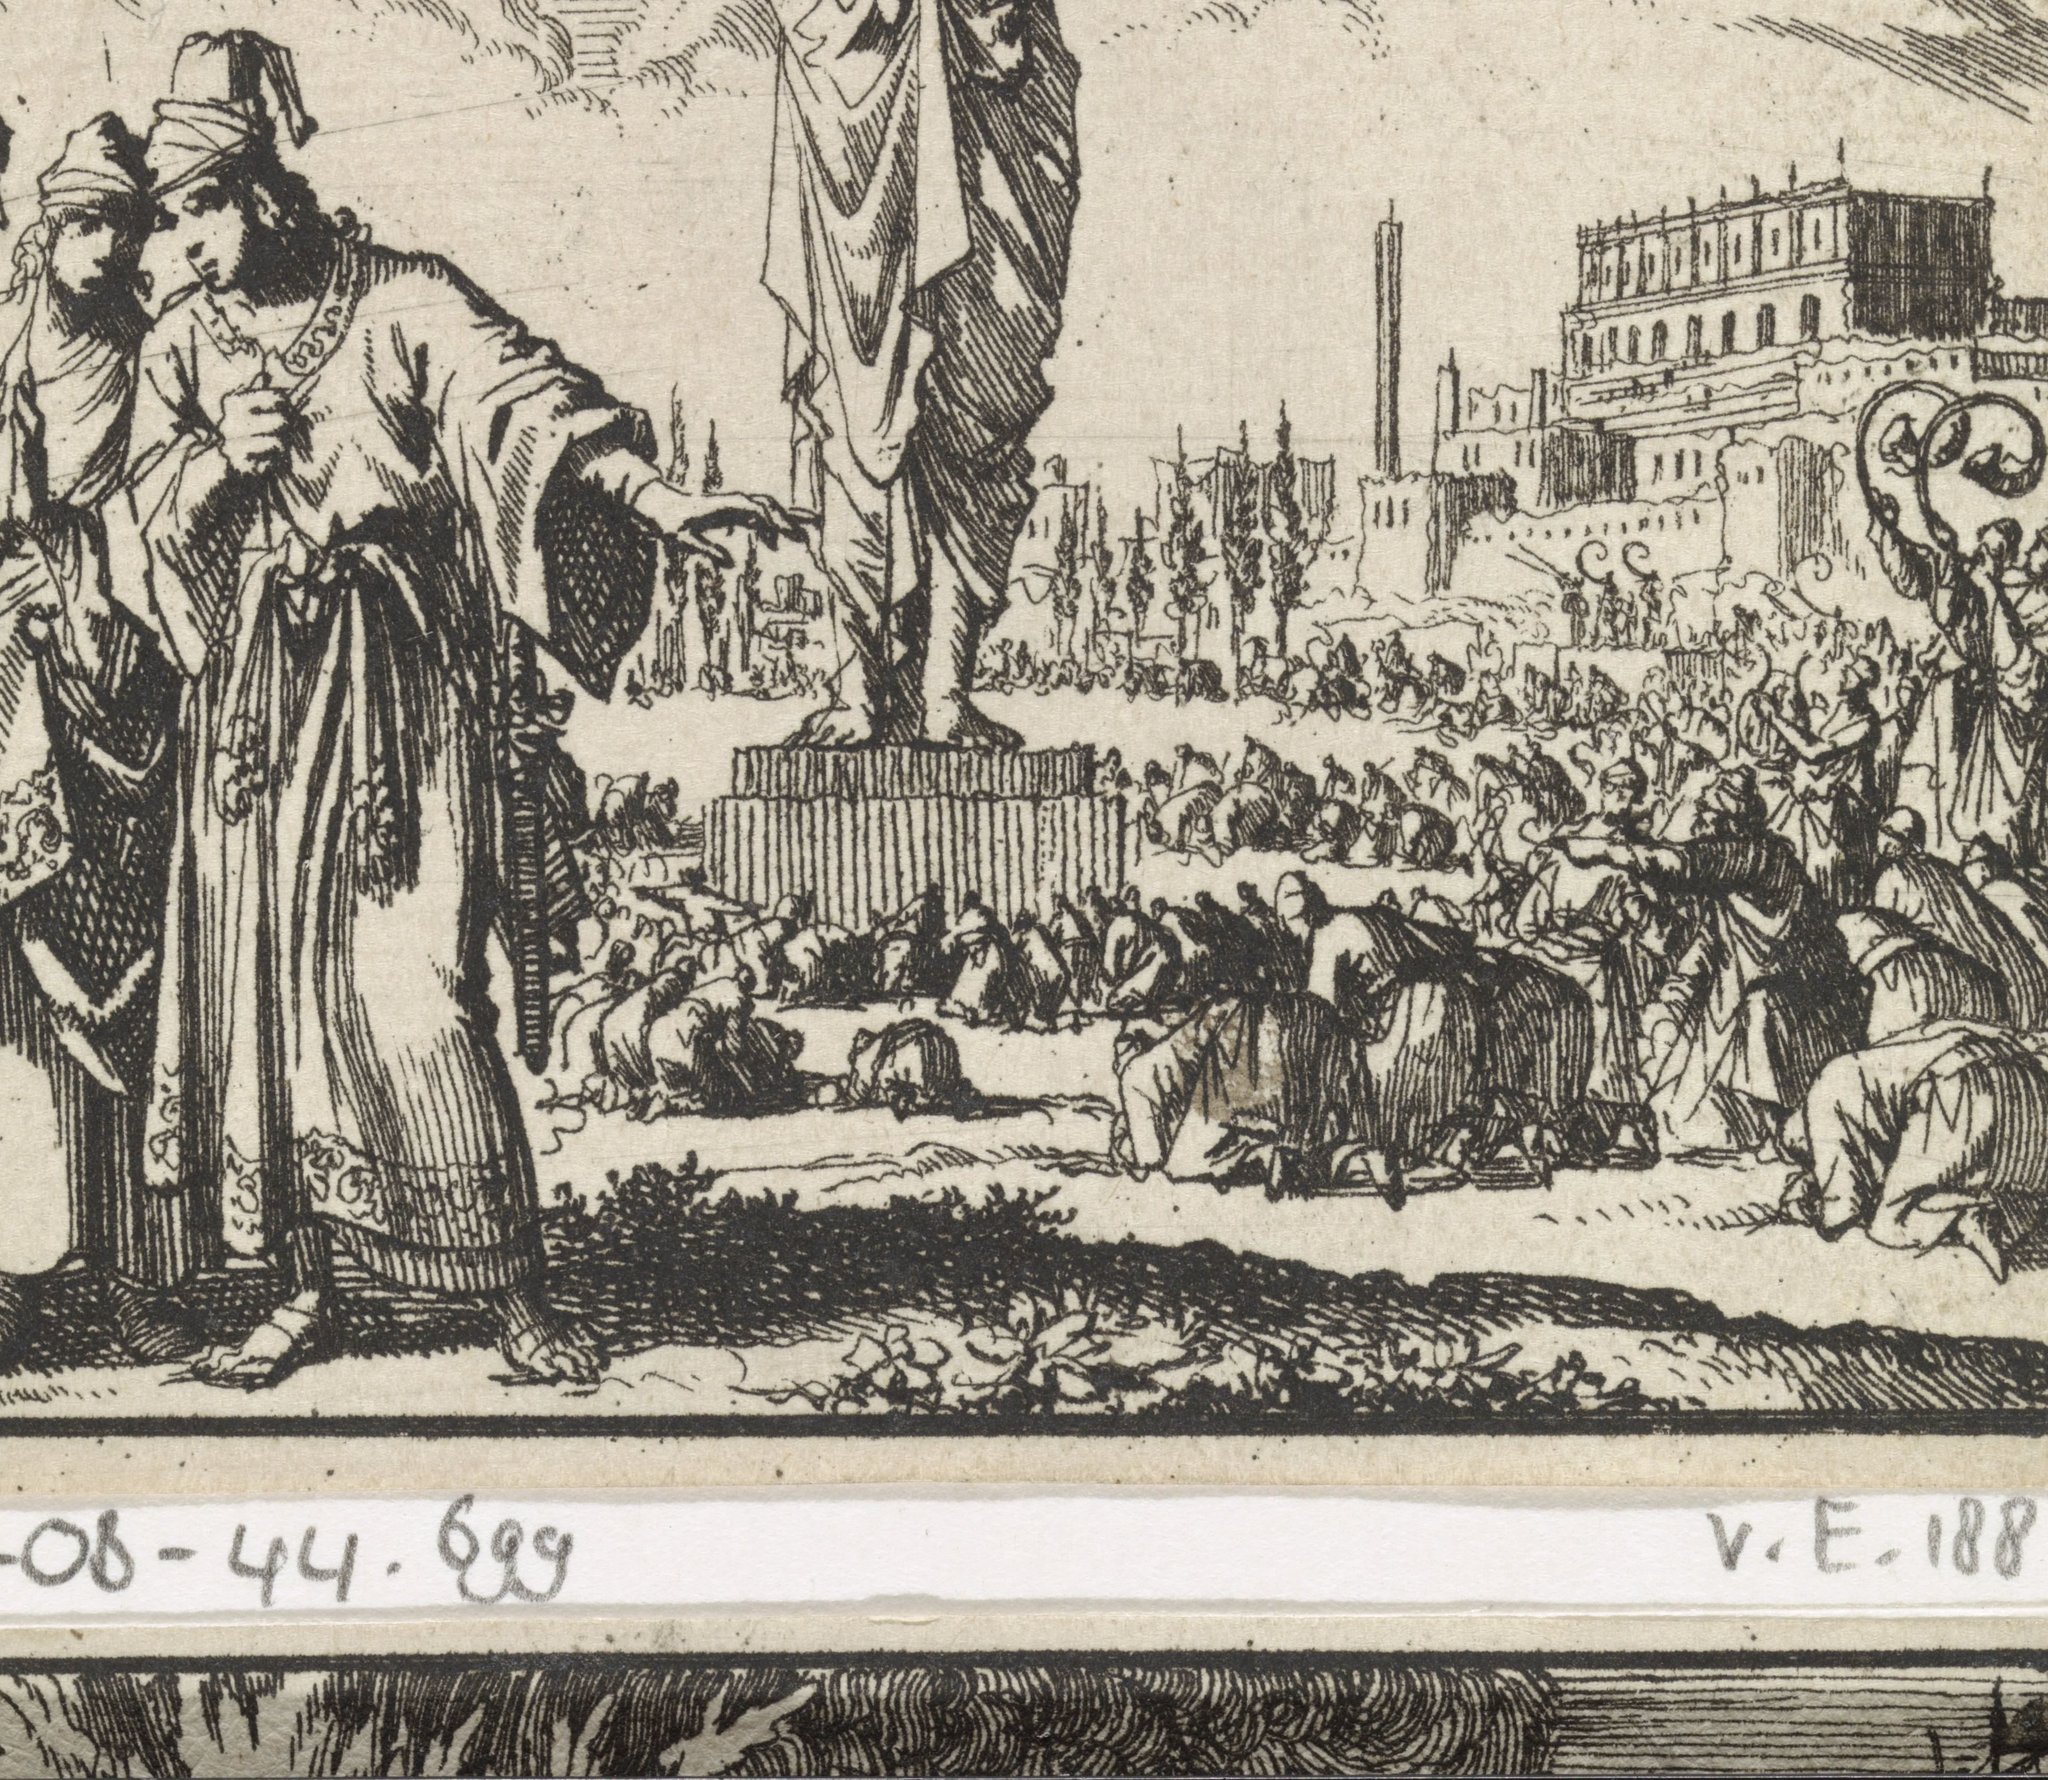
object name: print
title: Het afgodsbeeld van Nebukadnezar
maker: jan luyken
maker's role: draughtsman, print maker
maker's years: 1649-1712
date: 1698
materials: paper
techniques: etching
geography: amsterdam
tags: the dedication of the golden statue: in the presence of king nebuchadnezzar, trumpets are blown and all the people surrounding the image fall on their knees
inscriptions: collector's mark: Lugt 2228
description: Proefdruk van illustratie uit: Josephus, Flavius. XX. boeken van de oude geschiedenissen der joden, 4 delen. Amsterdam: Barent Visscher, Willem de Coup, Willem van Lamsveld, Andries van Damme, 1698, dl. I.